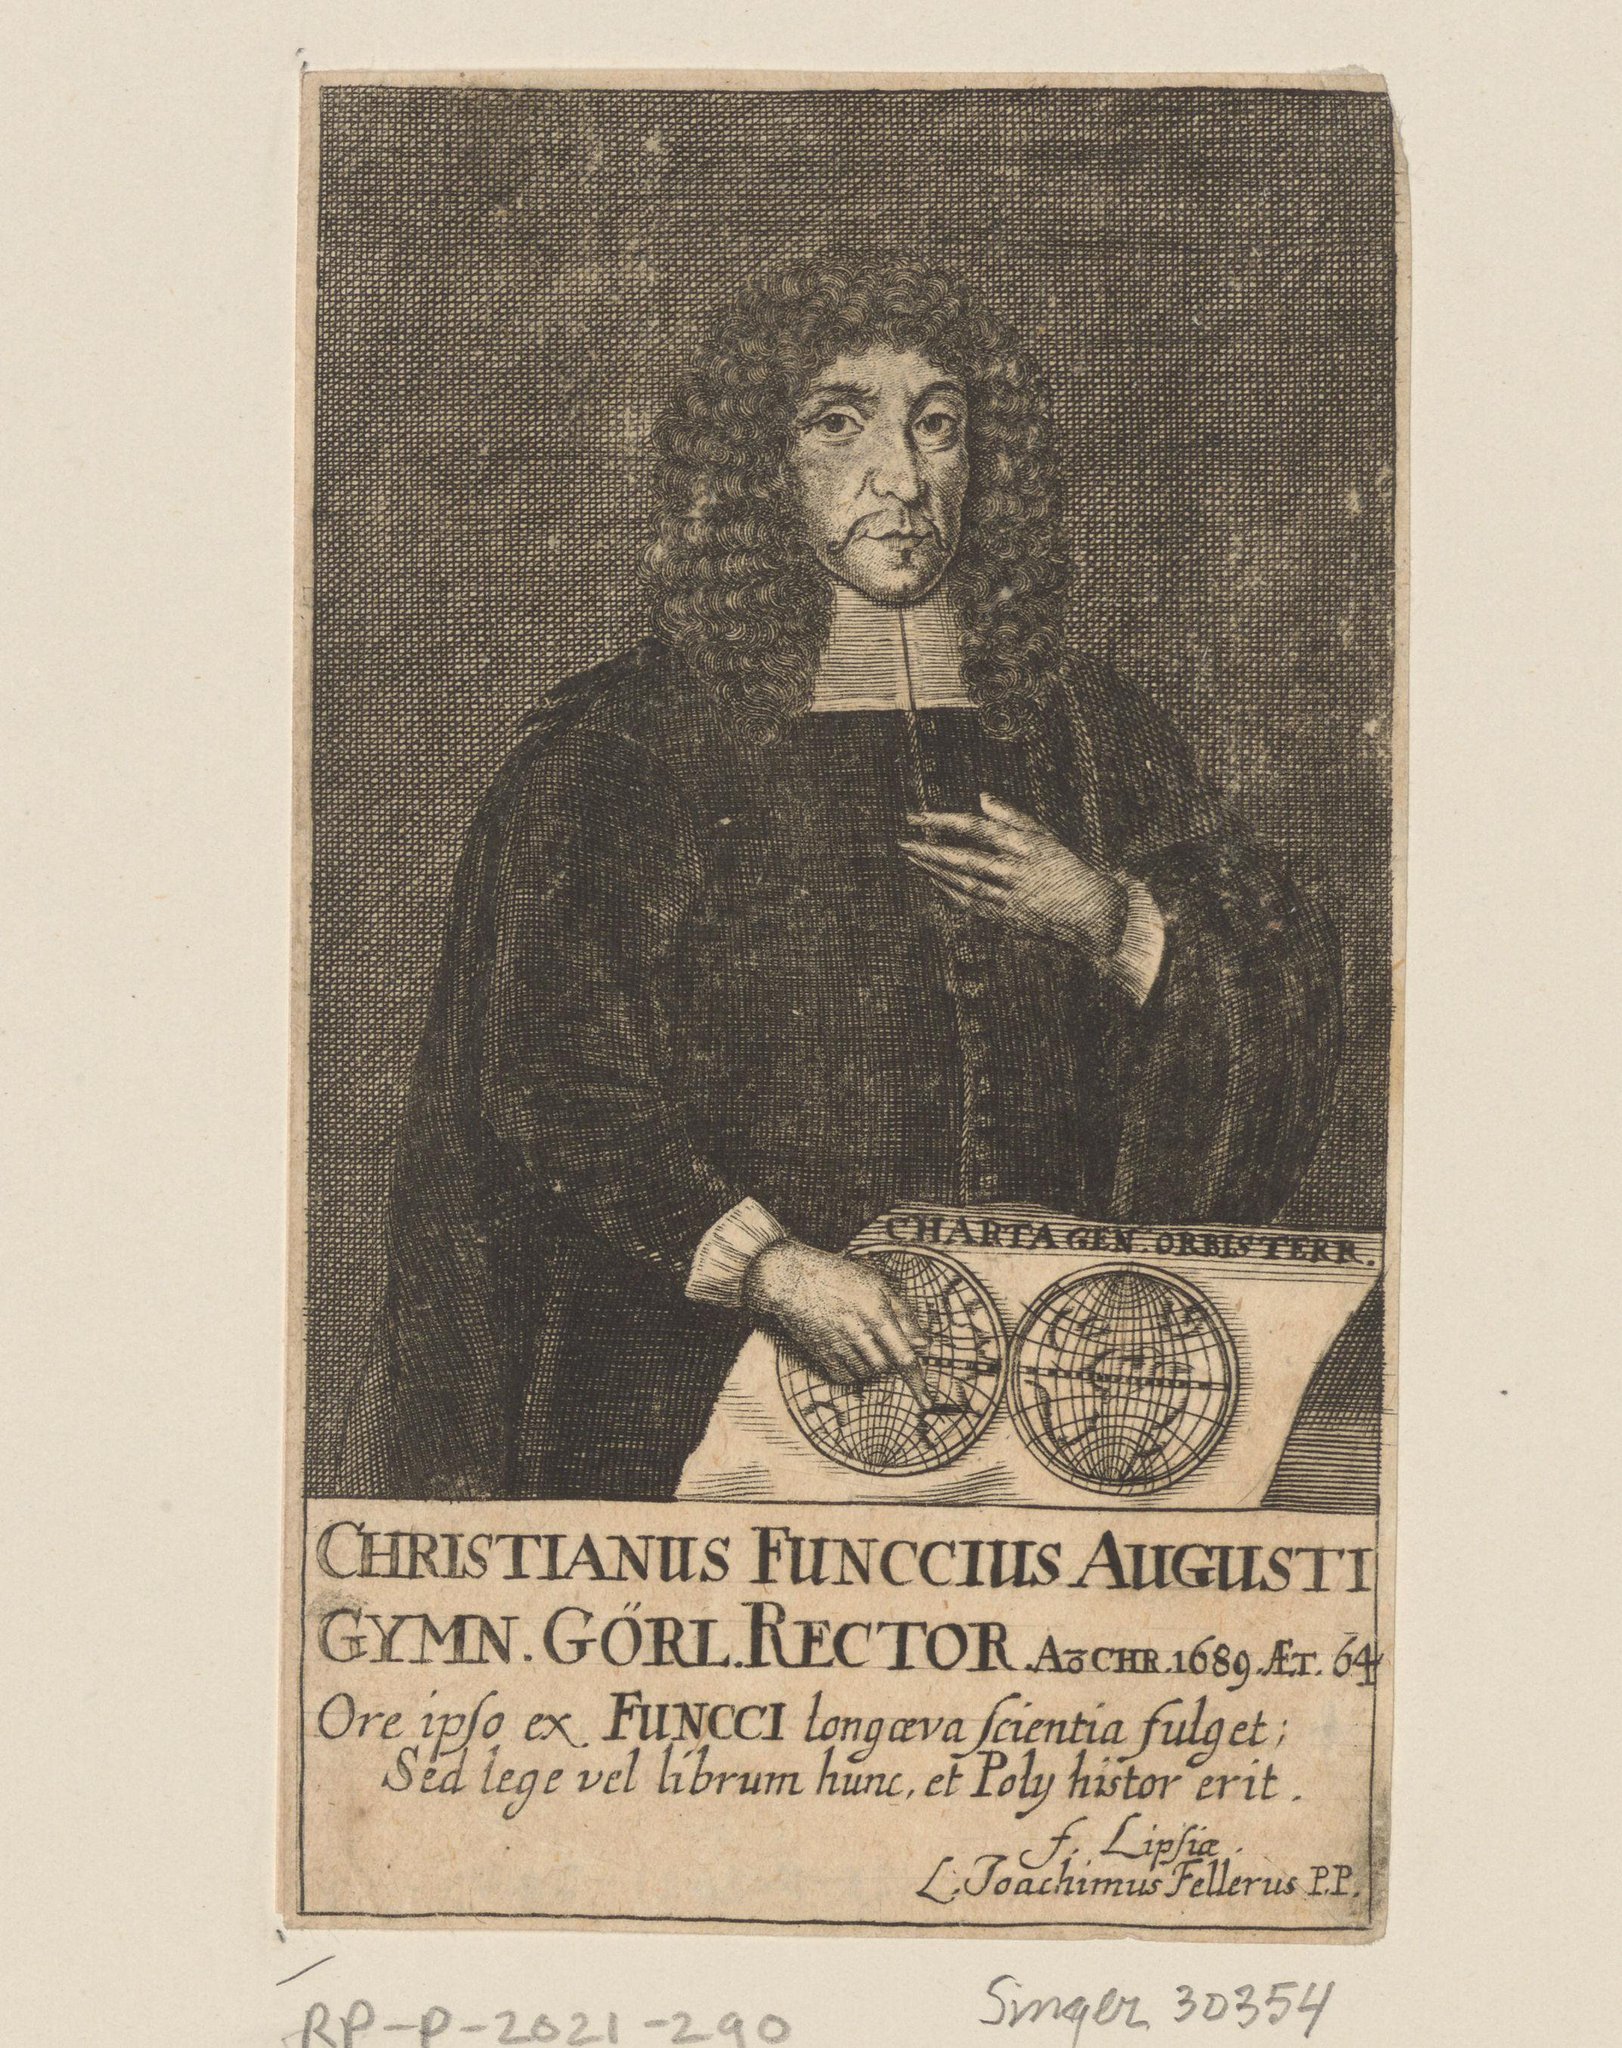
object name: print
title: Portret van Christian Funcke op 64-jarige leeftijd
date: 1689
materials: paper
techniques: engraving, etching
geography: germany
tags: historical persons, map of the world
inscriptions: inscription: ‘In der [...]/ Scintillantis [...]/ Symbolum [...] Je/ hovah jireh [...]’